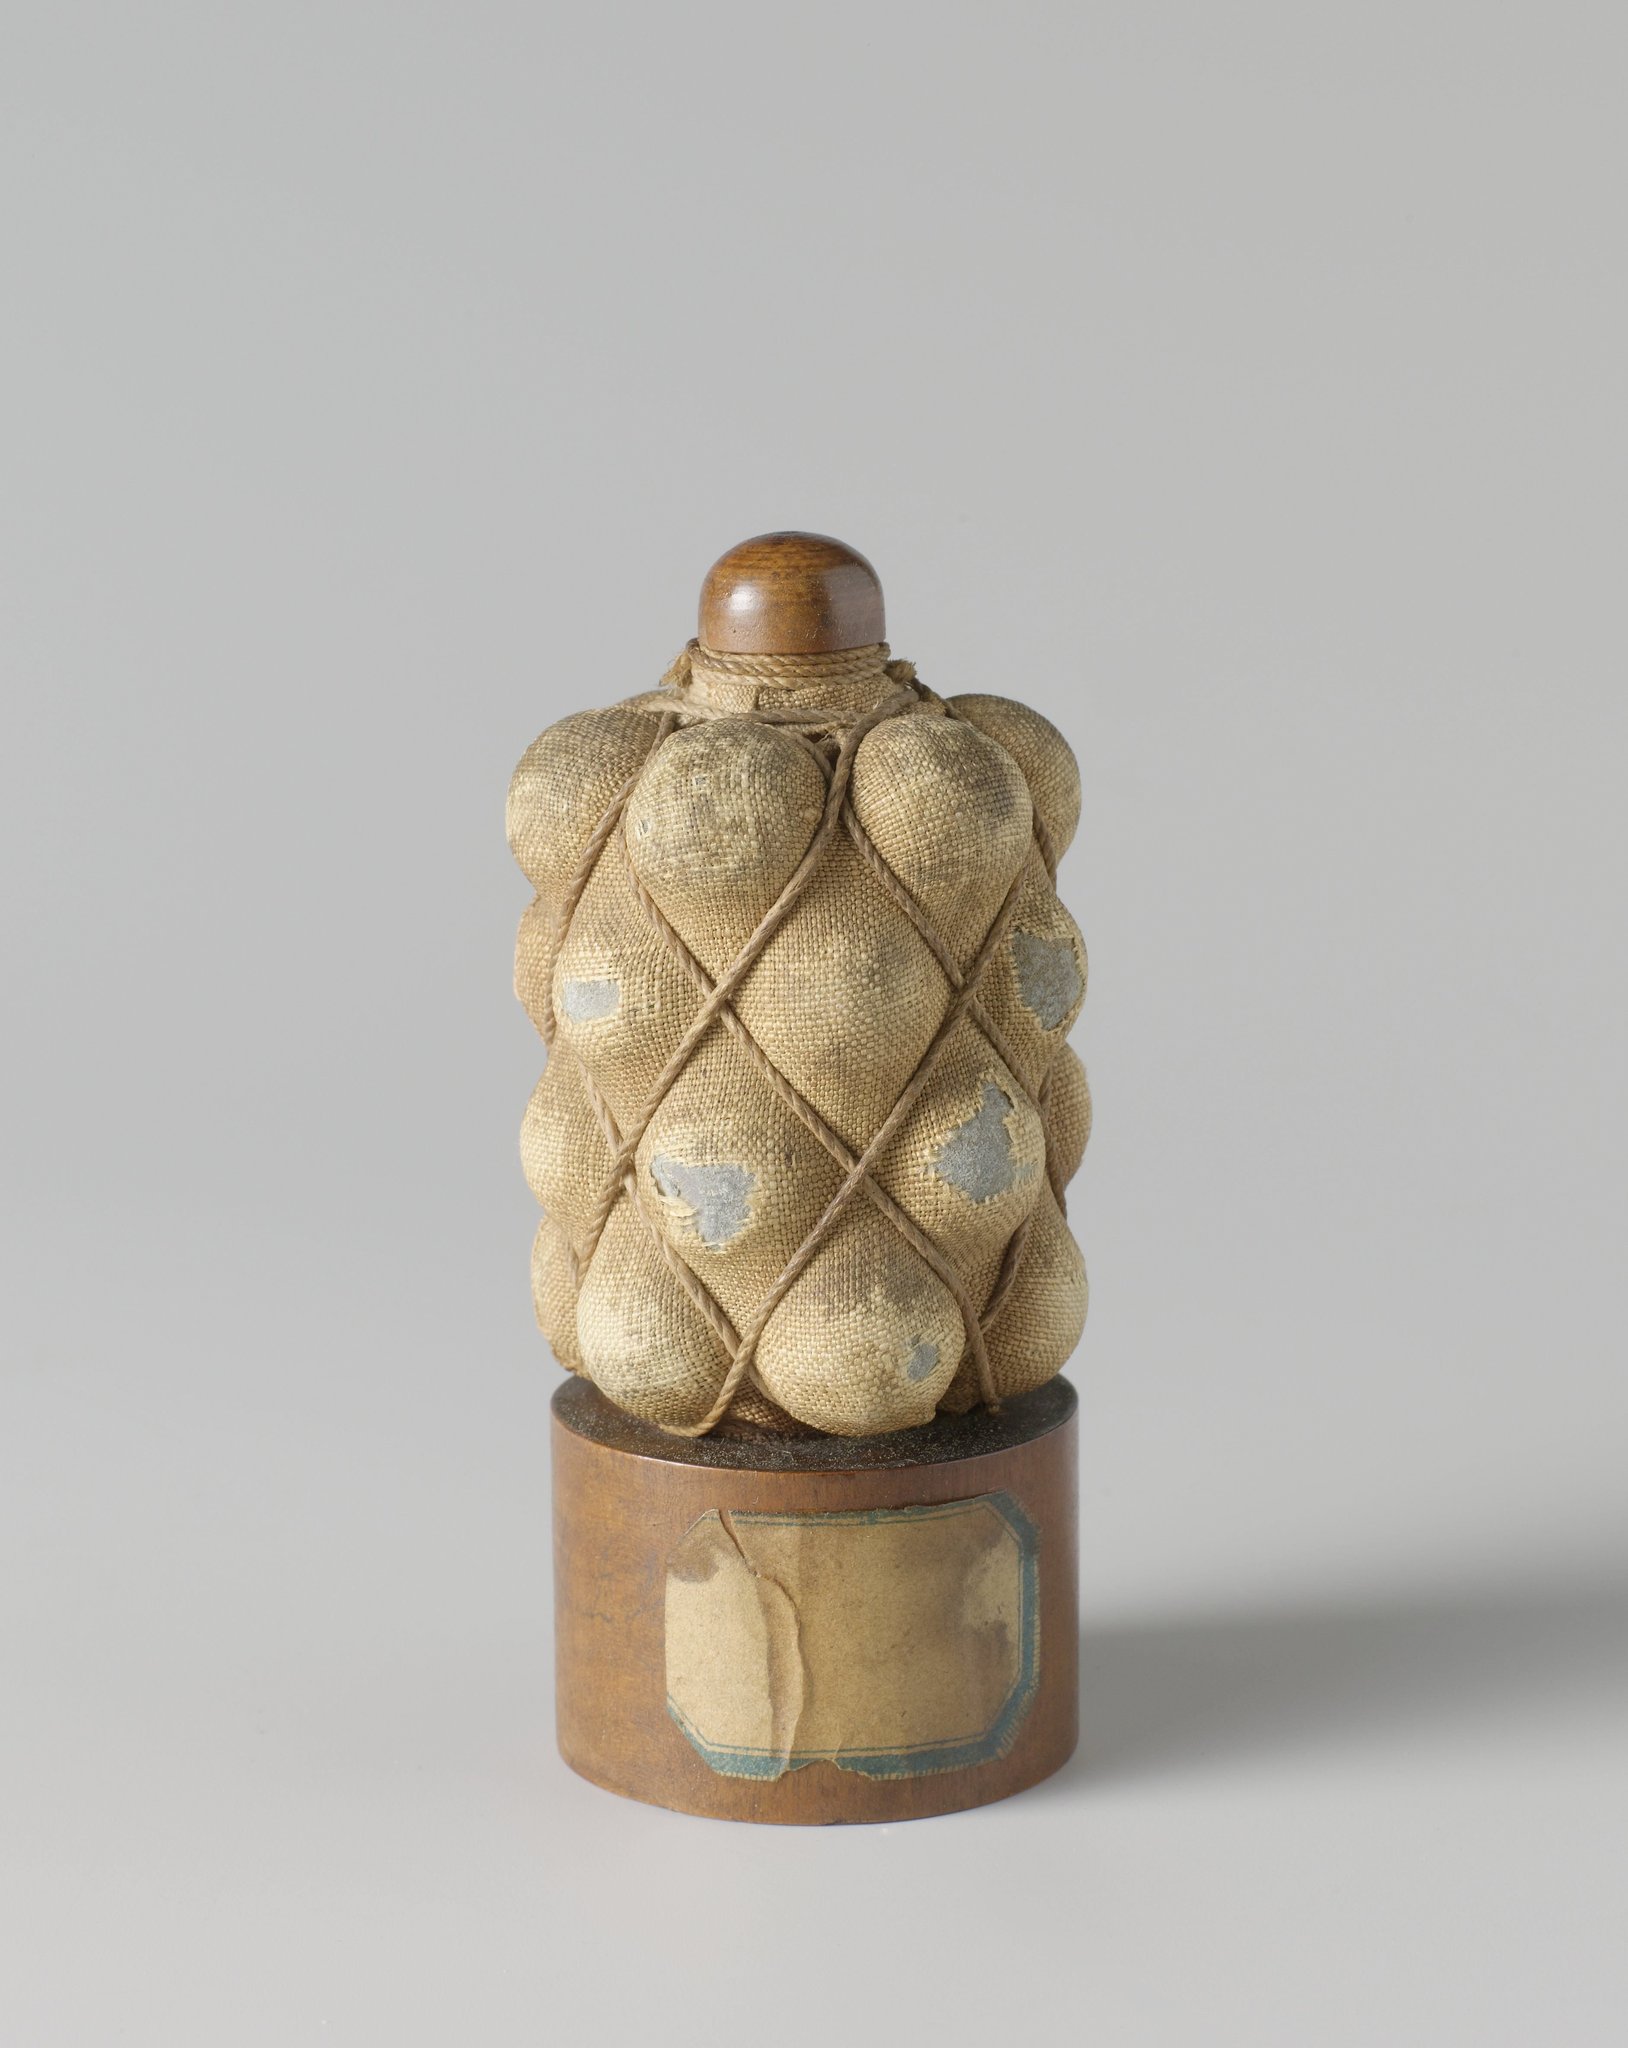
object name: scale model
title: Models of shot bundles (grapeshot)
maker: Anonymous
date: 1750-1800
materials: iron, linen, wood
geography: netherlands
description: A cannon could be loaded with a single cannonball or bundles of smaller projectiles, such as this ‘grapeshot’. Grapeshot consisted of a canvas bag filled with iron balls or metal slugs, tied together so that it resembled a bunch of grapes. It was used to hit living targets – horses and soldiers – at close range. The Dutch word for machine gun (mitrailleur) comes from the French term for grapeshot (boîte à mitraille).